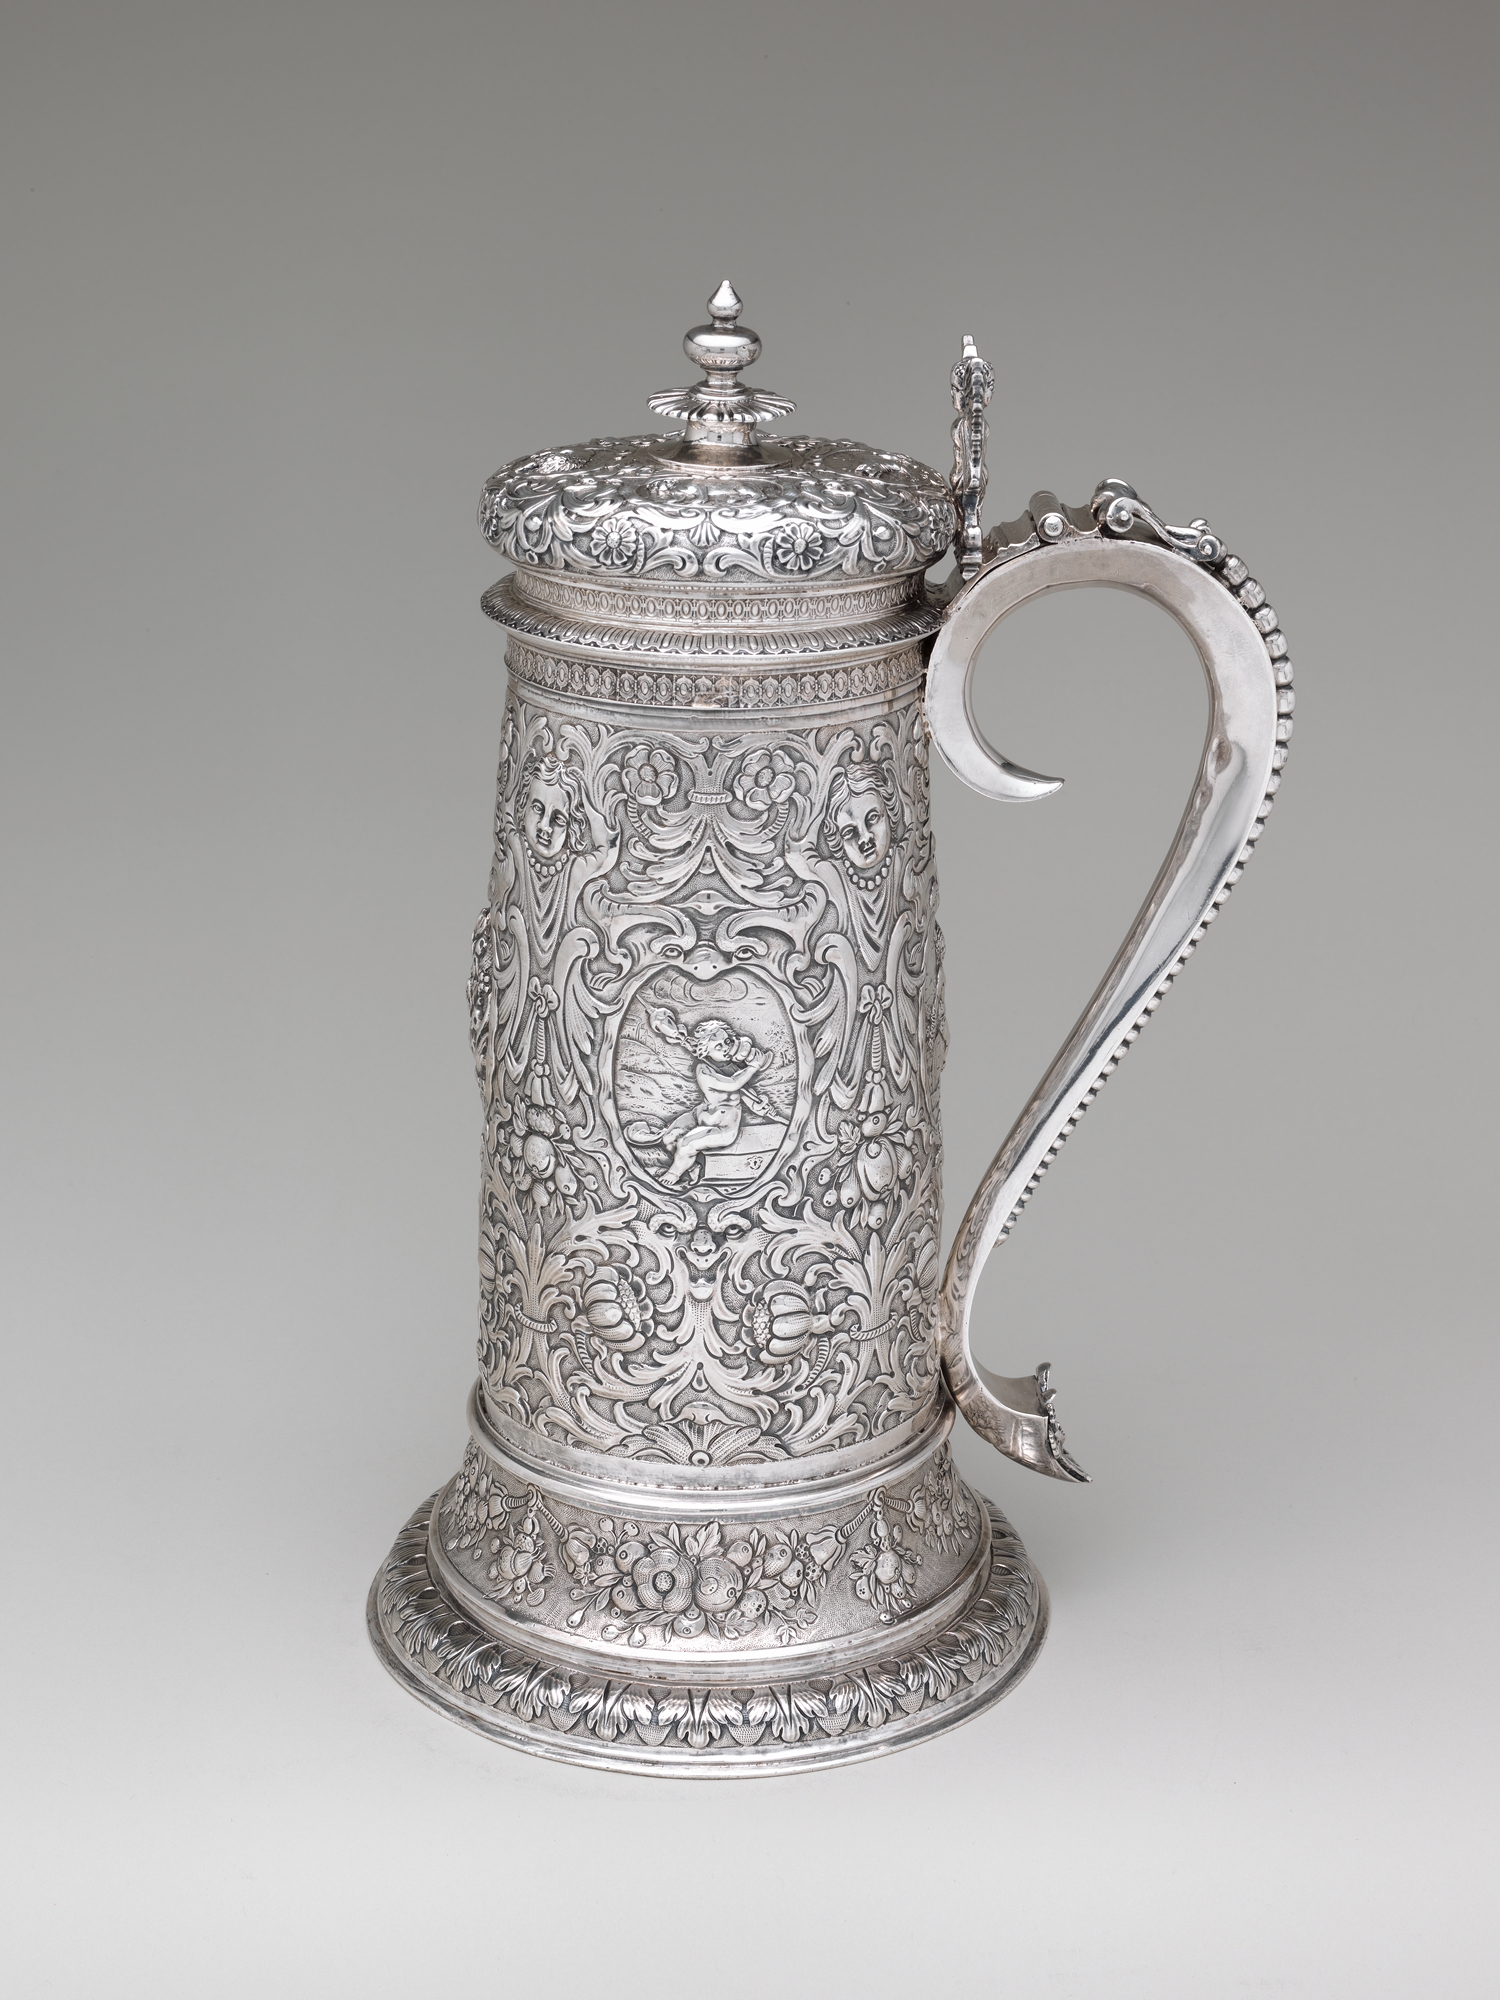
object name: flagon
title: Flagon (one of a pair)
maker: richard blackwell ii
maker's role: maker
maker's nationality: british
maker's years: 1646-1670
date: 1646-1647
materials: gilt silver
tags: faces,boys